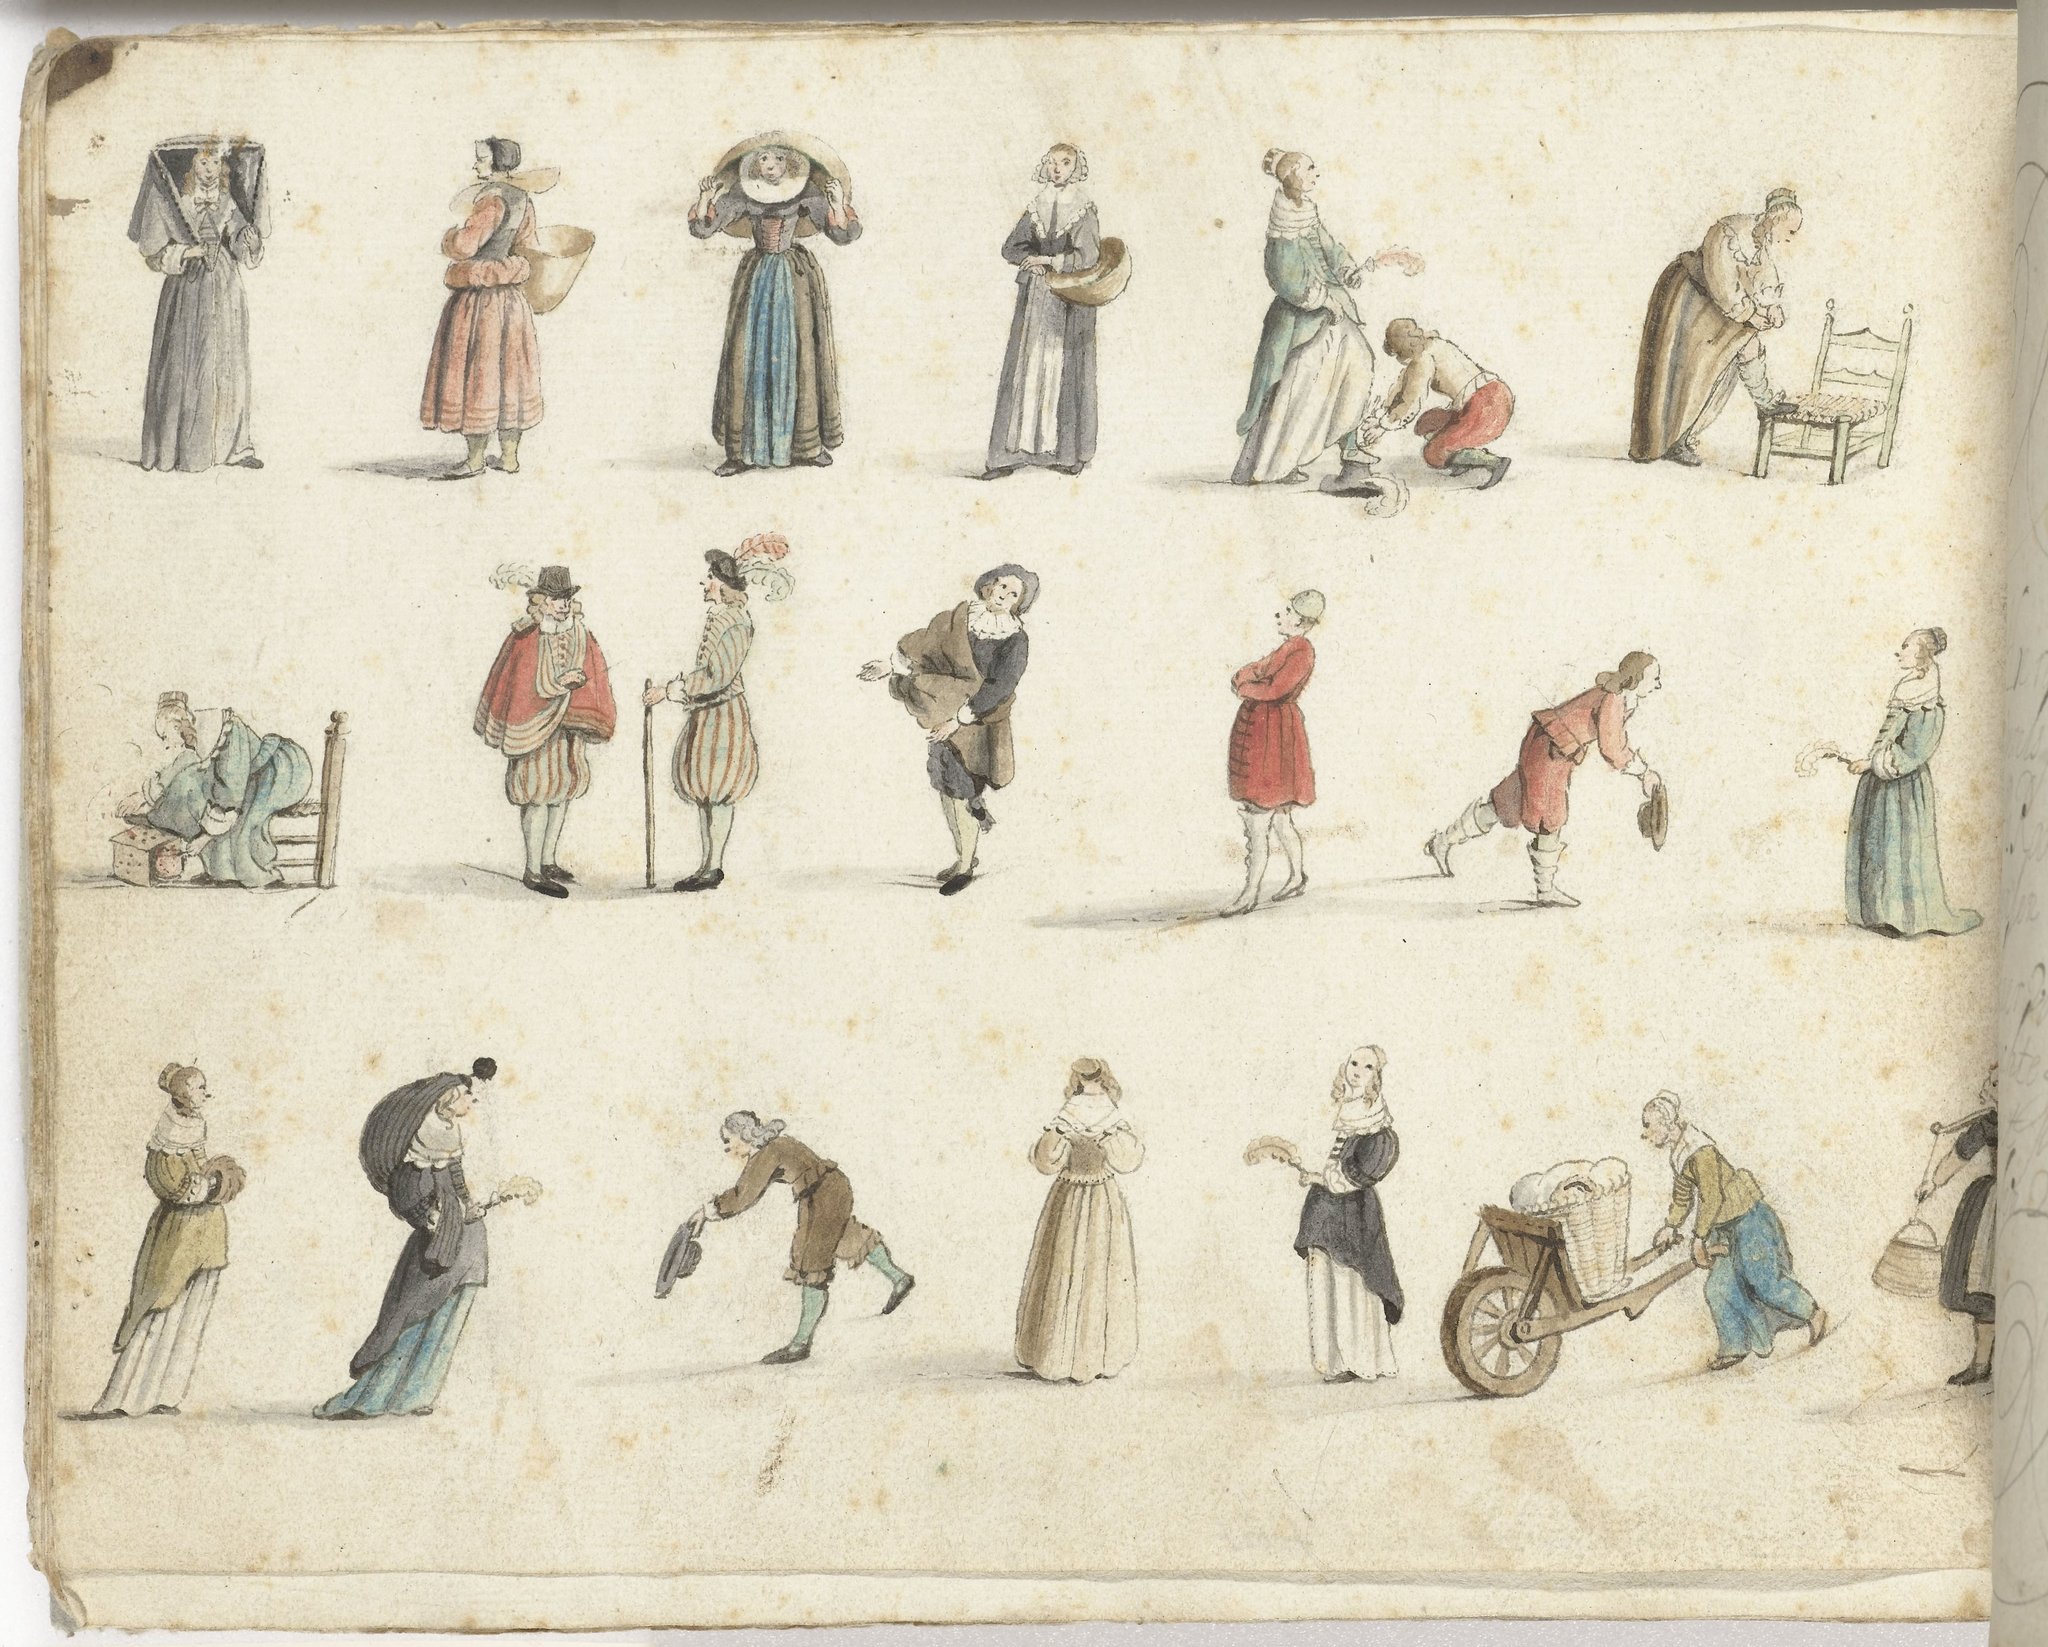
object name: drawing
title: Figuurstudies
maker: gesina ter borch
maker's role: draughtsman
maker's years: 1633-1690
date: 1648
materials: ink, paper, watercolor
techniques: brush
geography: zwolle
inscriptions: date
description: Tekening op verso; op papier dat oorspronkelijk gevouwen was in het midden, ingevoegd toen het boek opnieuw werd ingebonden. Twee van de figuren zijn herhaald op folio 9 van het Materi-Boeck. De figuurstudies werden ook jaren later nog door Gesina gebruikt als modellen in haar kunst.